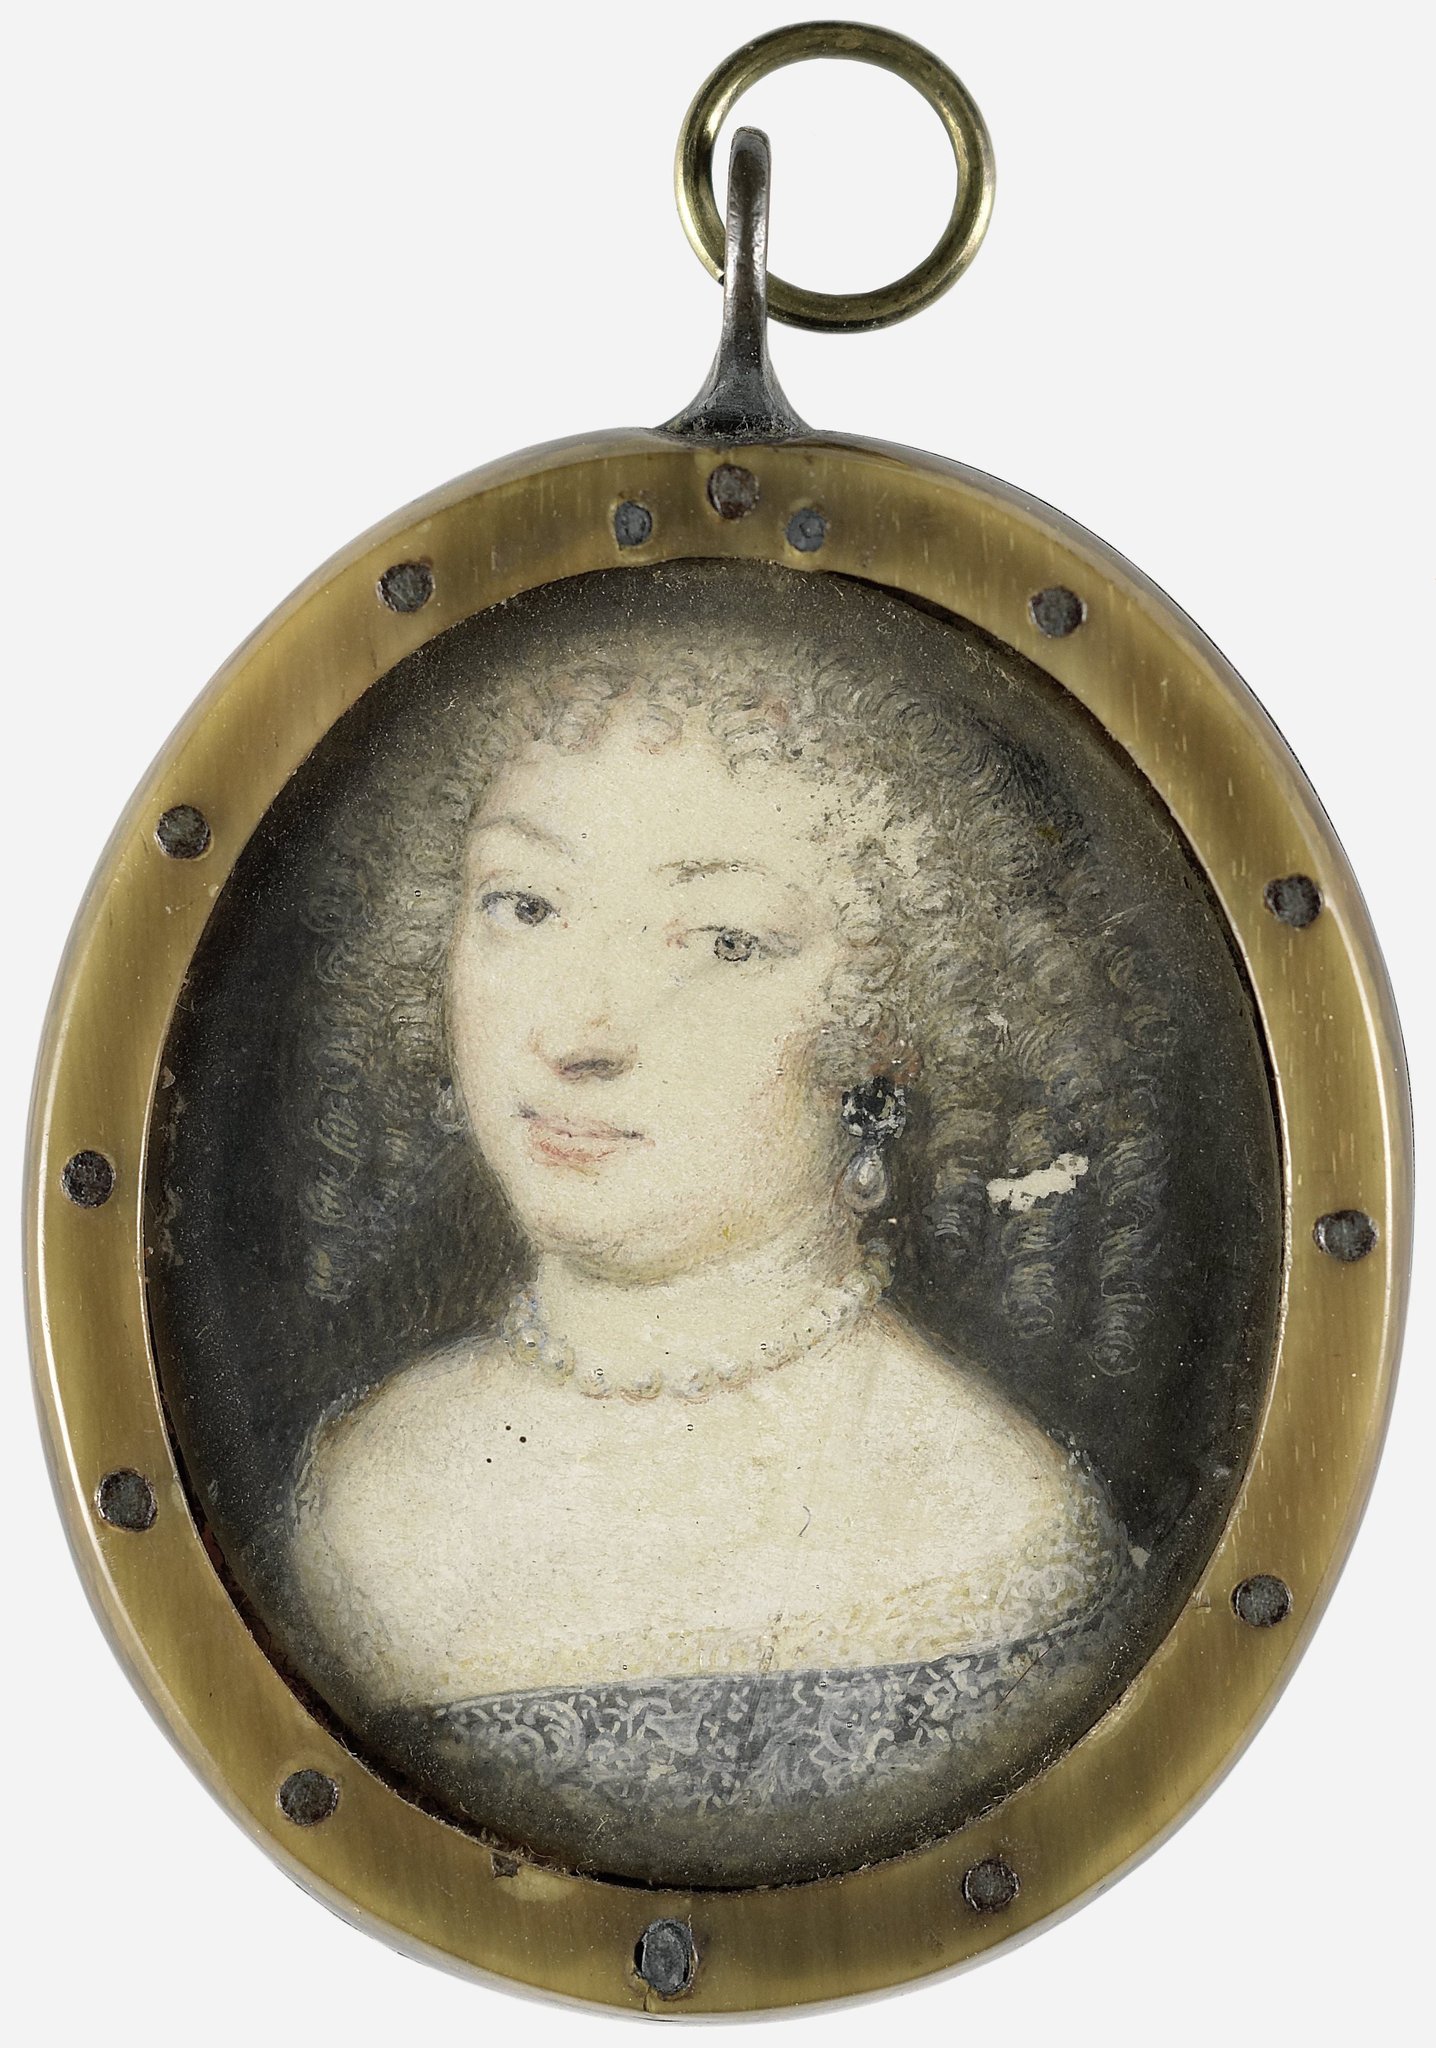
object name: painting, miniature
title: Marie, markiezin van Sévigné (1626-96)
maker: Anonymous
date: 1660-1670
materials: cardboard, glass, metal, shell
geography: france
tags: paris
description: Portret van Marie, markiezin van Sévigné (1626-96), Buste naar links, aanziend. Naar een pastel door Robert Nanteuil in het Musée Carnavalet te Parijs. Onderdeel van de collectie portretminiaturen.